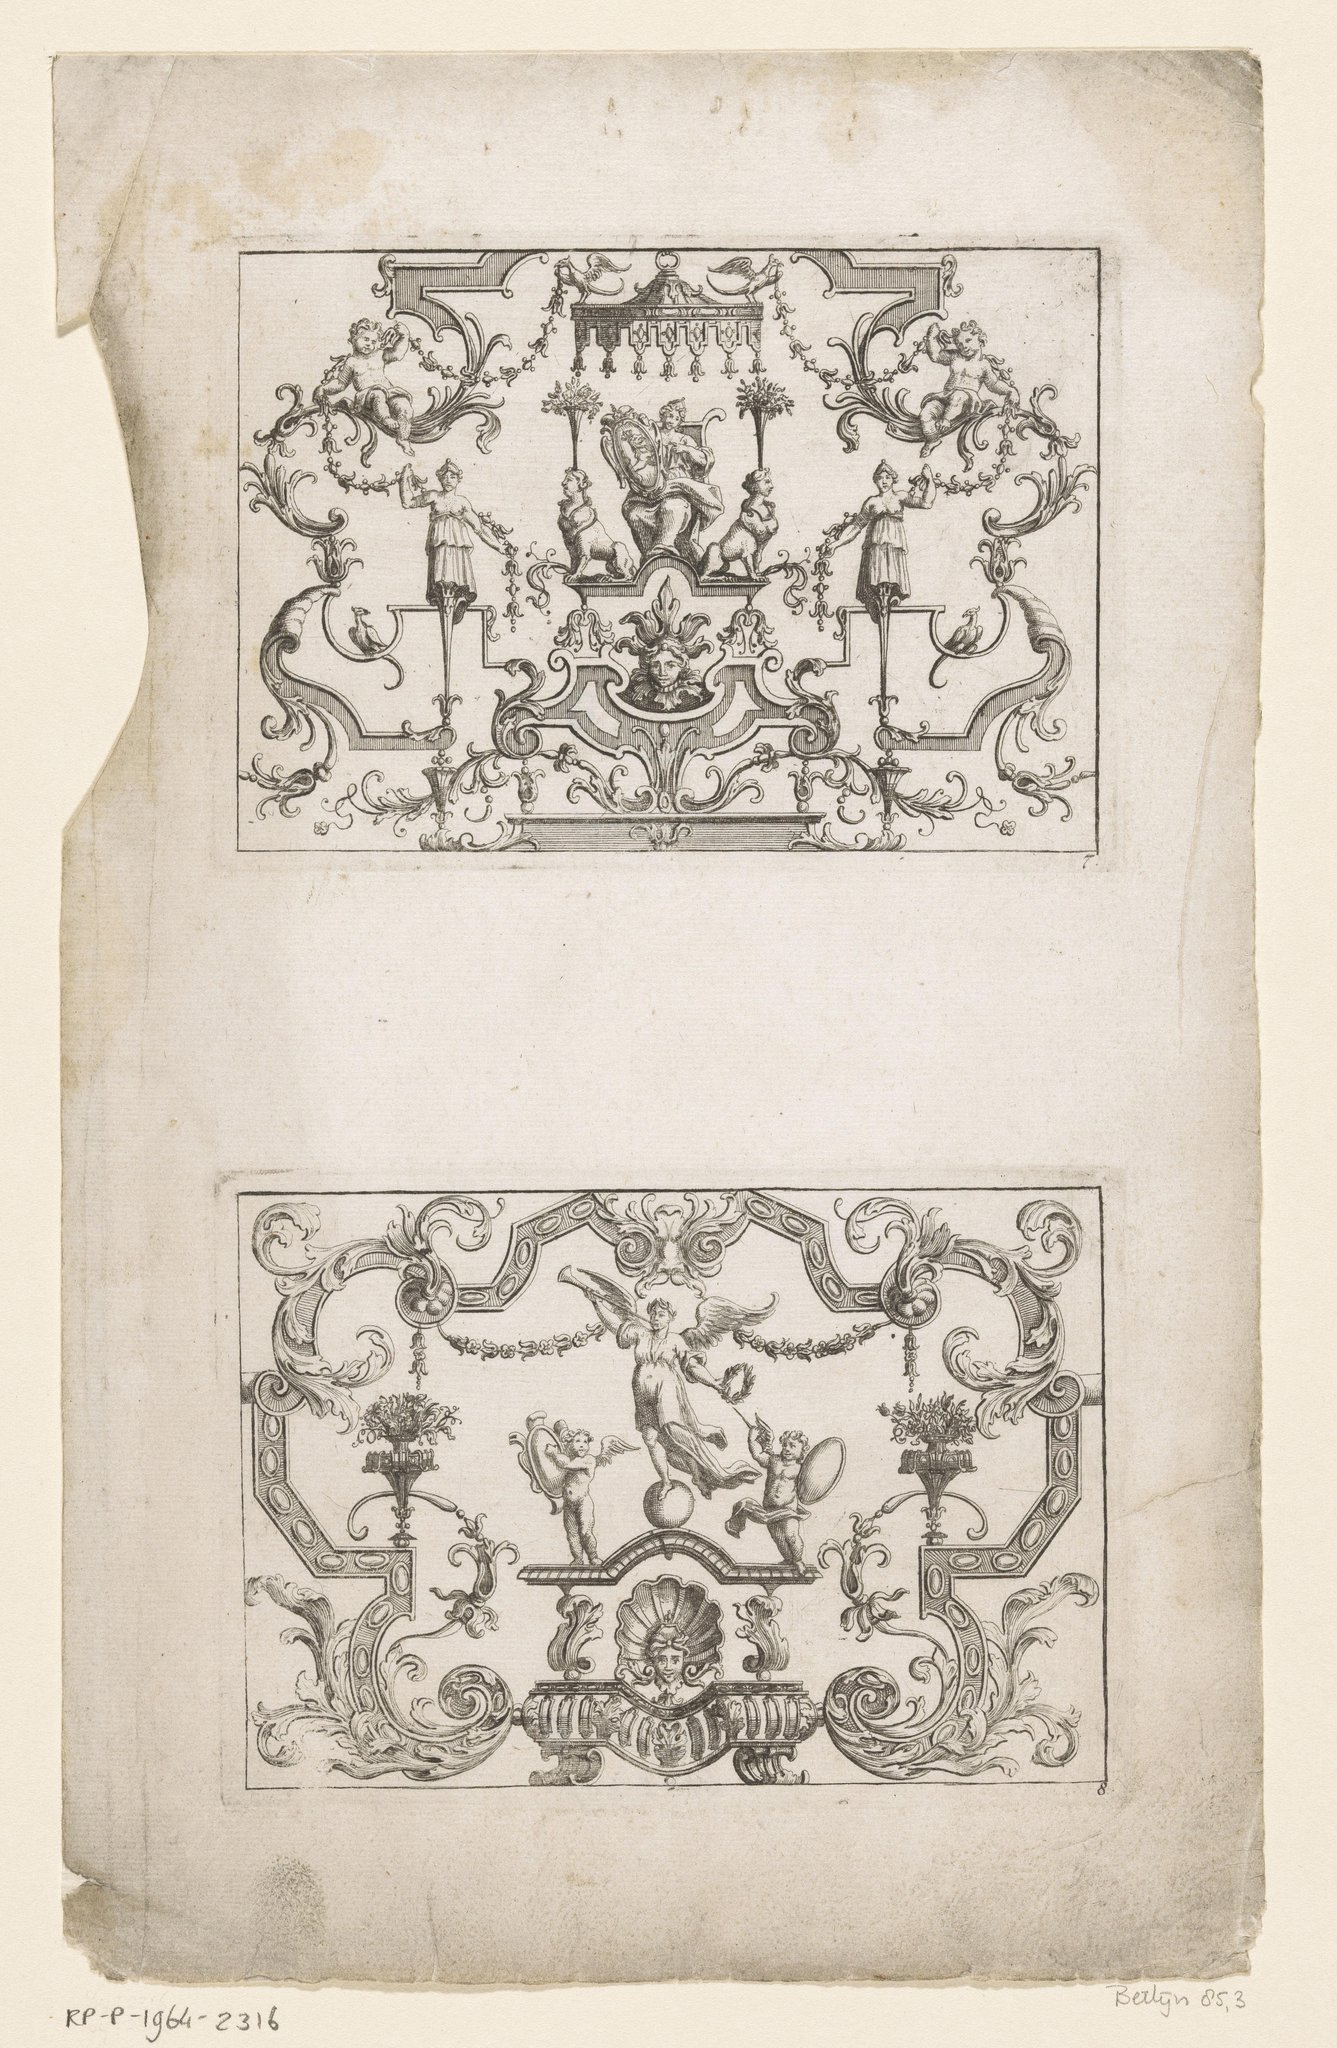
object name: print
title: Grotesken met vrouwenfiguren en putti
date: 1687-1725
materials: paper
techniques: etching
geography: nuremberg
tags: ornament ~ grotesque, victory, fama as roman personification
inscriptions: collector's mark: Lugt 2228, collector's mark: Lugt 2760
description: De bovenste prent bevat een tronende vrouw met een wapen onder een baldakijn. Op de onderste prent blaast Faam op haar bazuin. In haar andere hand heeft ze een lauwerkrans en ze staat op een globe. Ze wordt door putti geflankeerd.